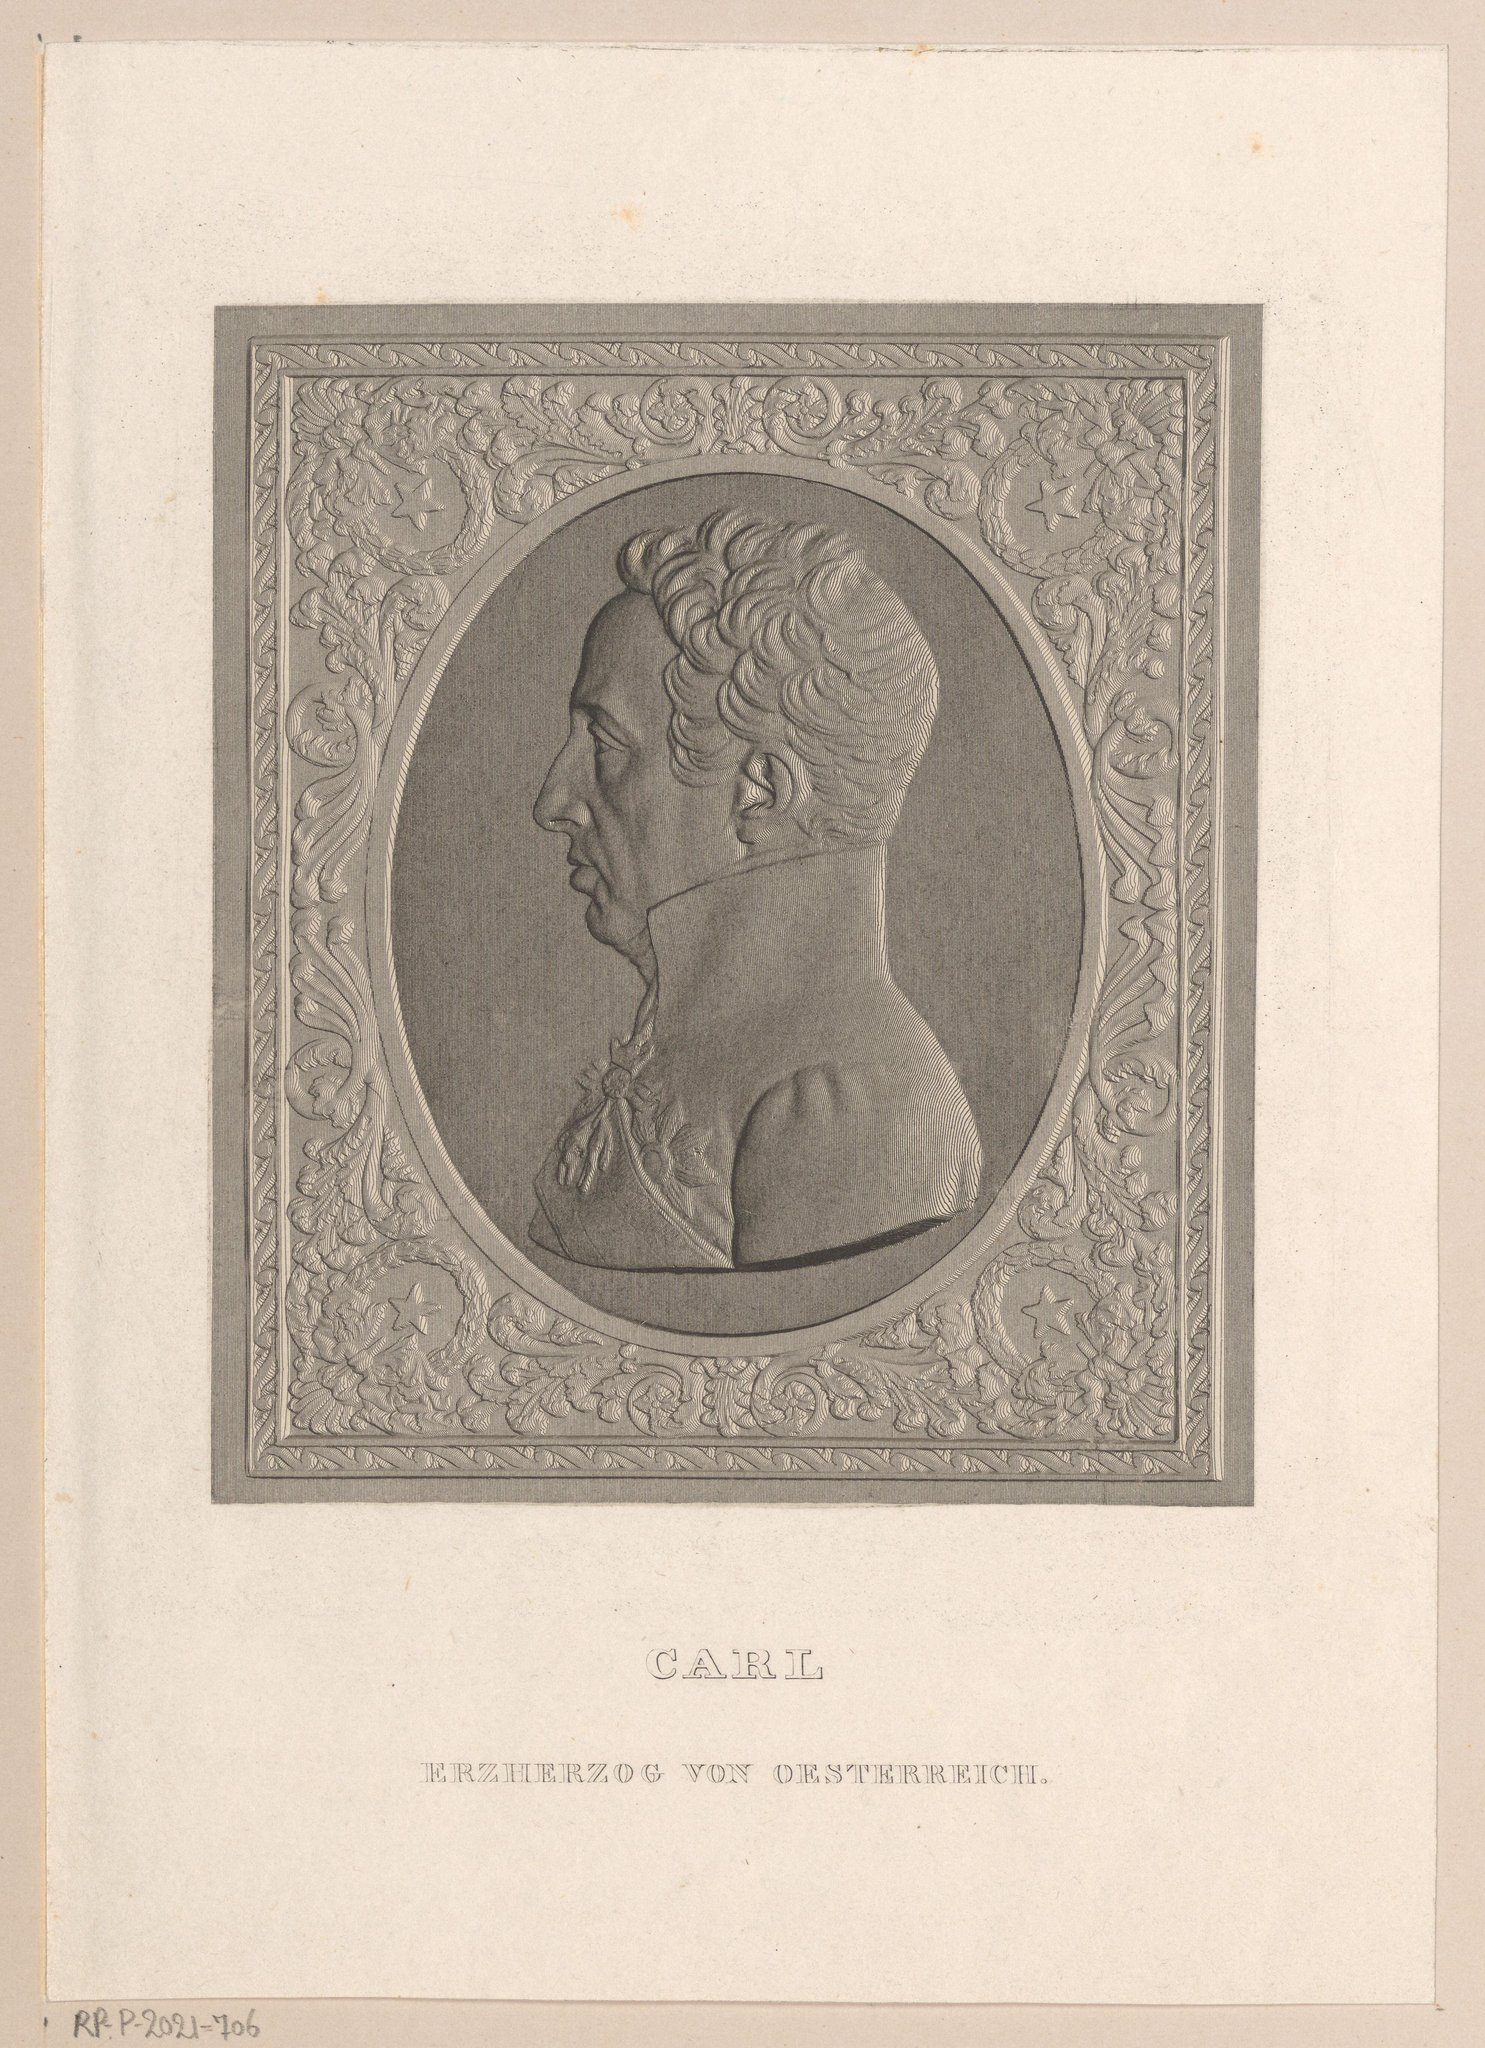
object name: print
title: Portret van Karel Lodewijk Johan, landvoogd der Zuidelijke Nederlanden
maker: Anonymous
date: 1800-1899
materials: paper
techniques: etching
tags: other sovereign, historical persons